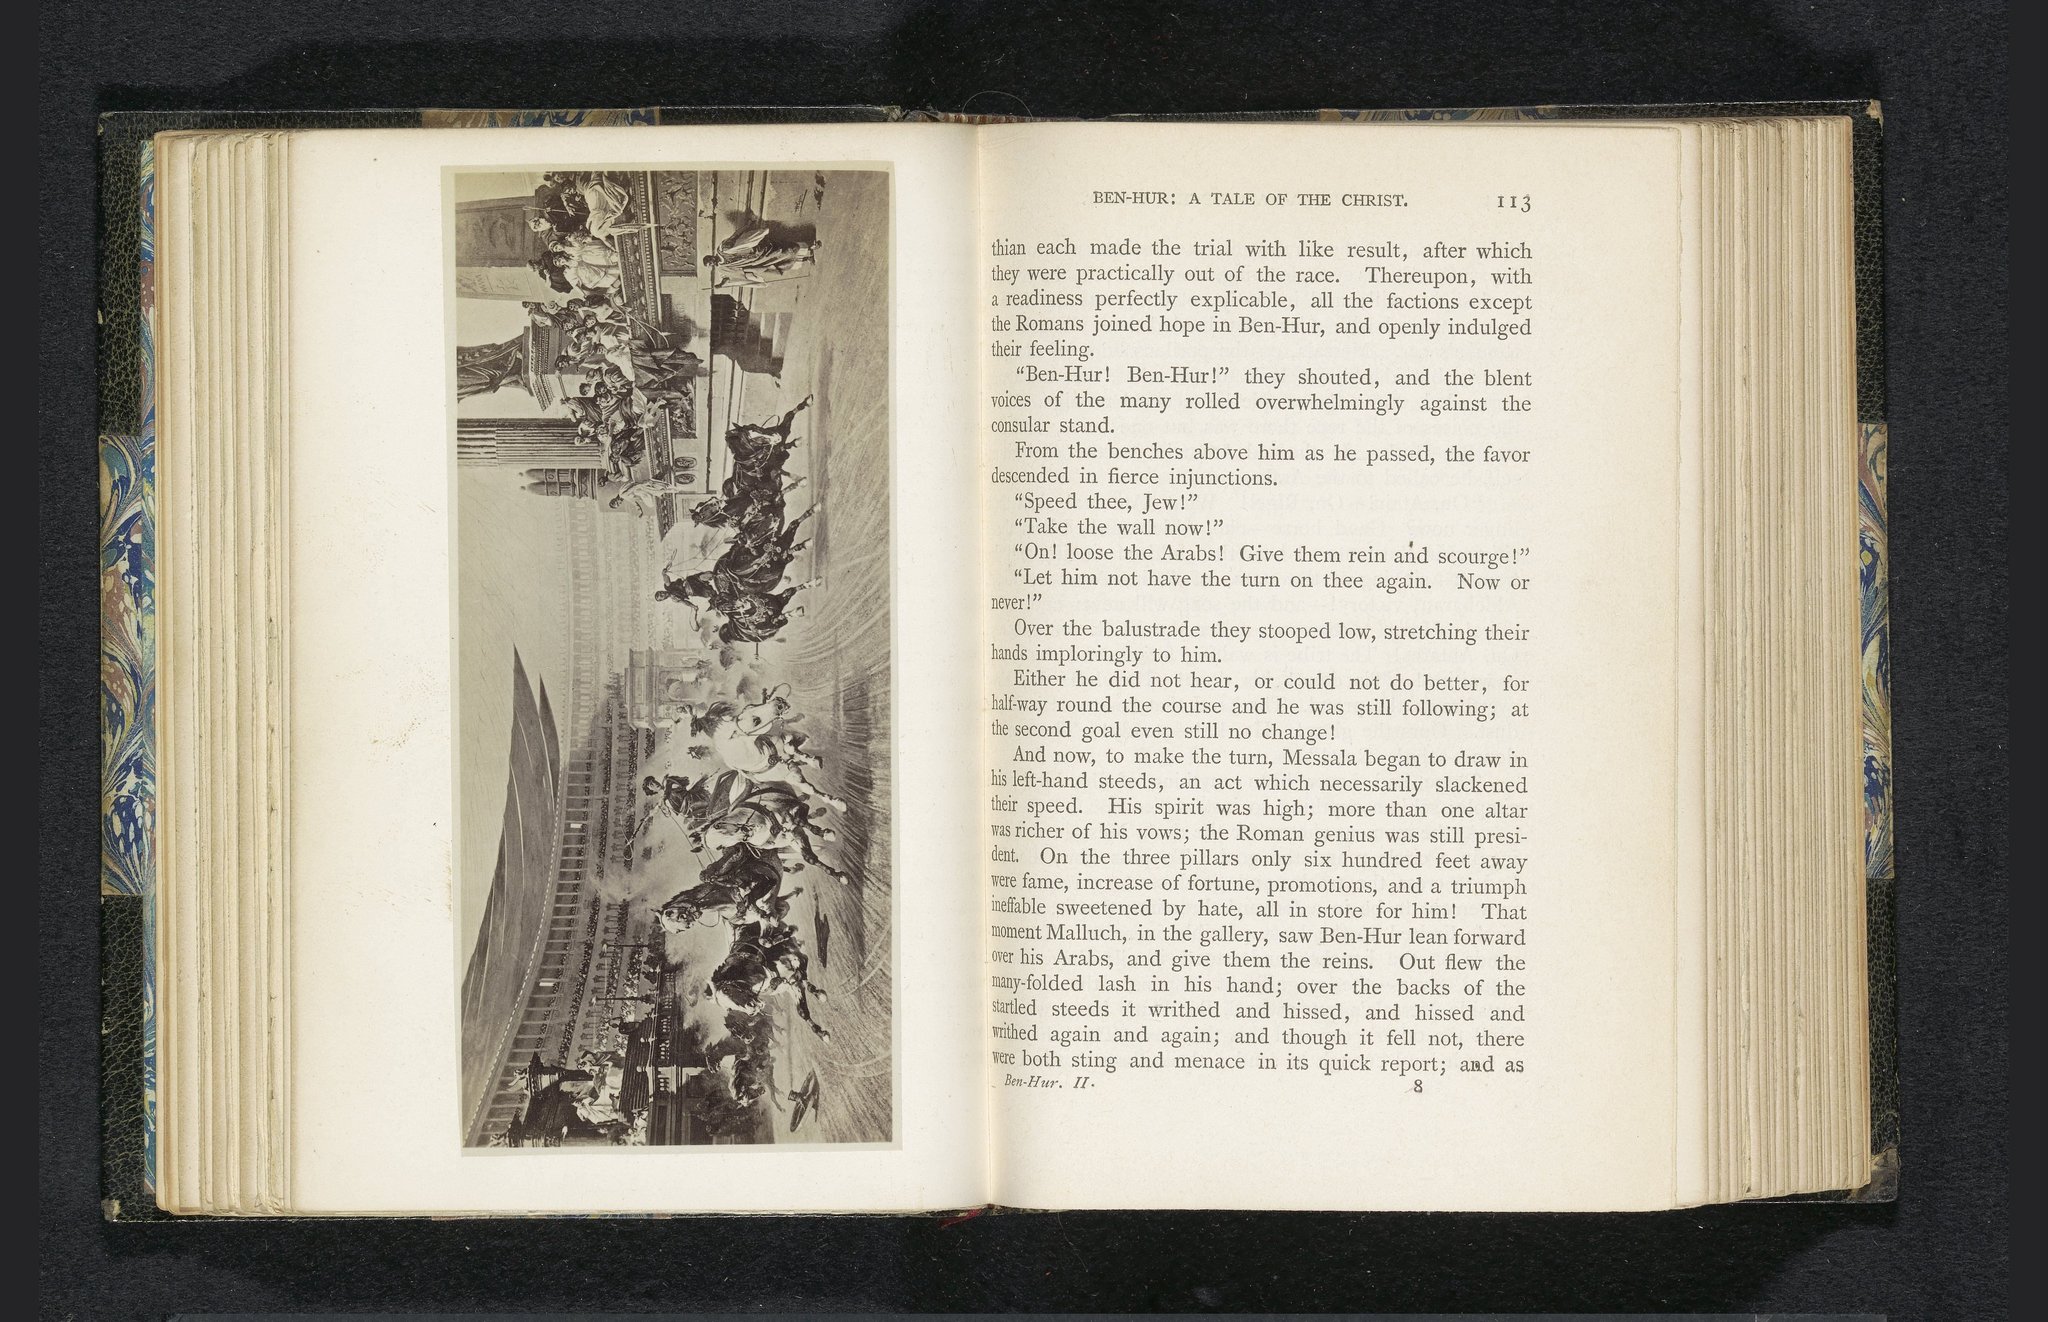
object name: reproduction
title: Fotoreproductie van een schilderij, voorstellende wagenrennen in het Circus Maximus te Rome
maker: Anonymous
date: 1883-1888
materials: photographic support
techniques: albumen print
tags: chariot, triumphal car, race-track